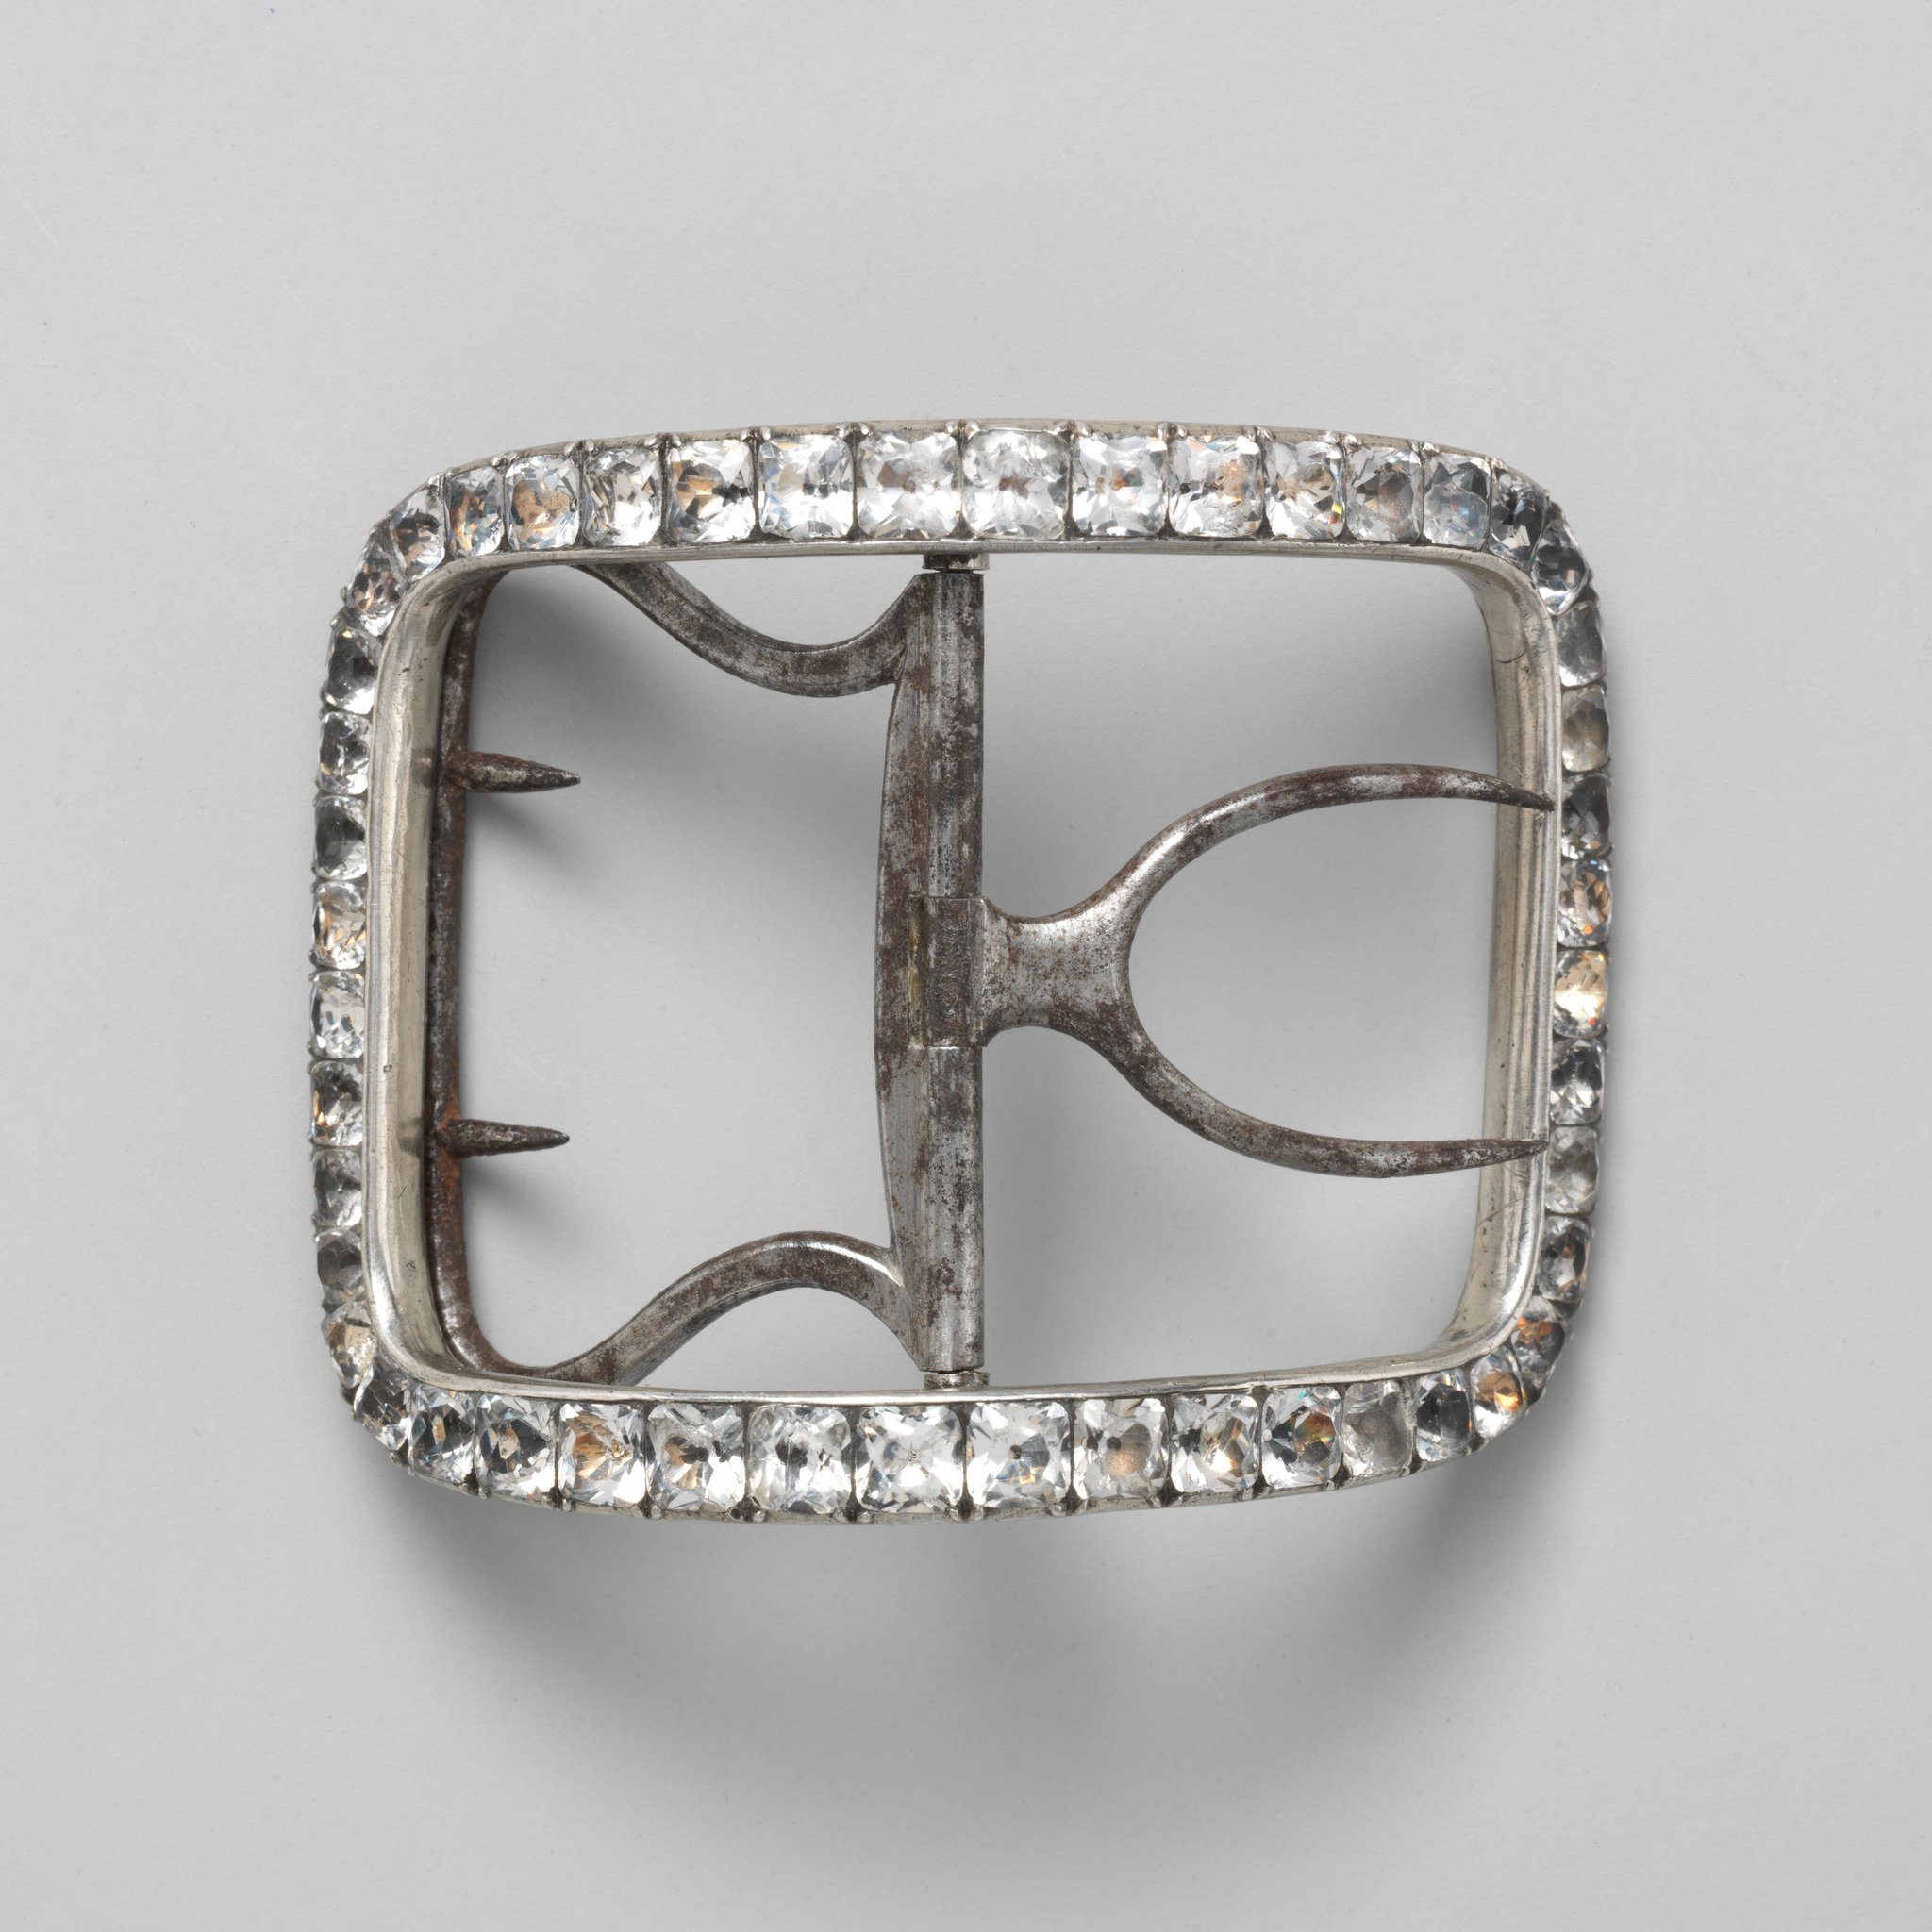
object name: shoe buckle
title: Shoe buckles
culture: british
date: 1767-1800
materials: metal, paste